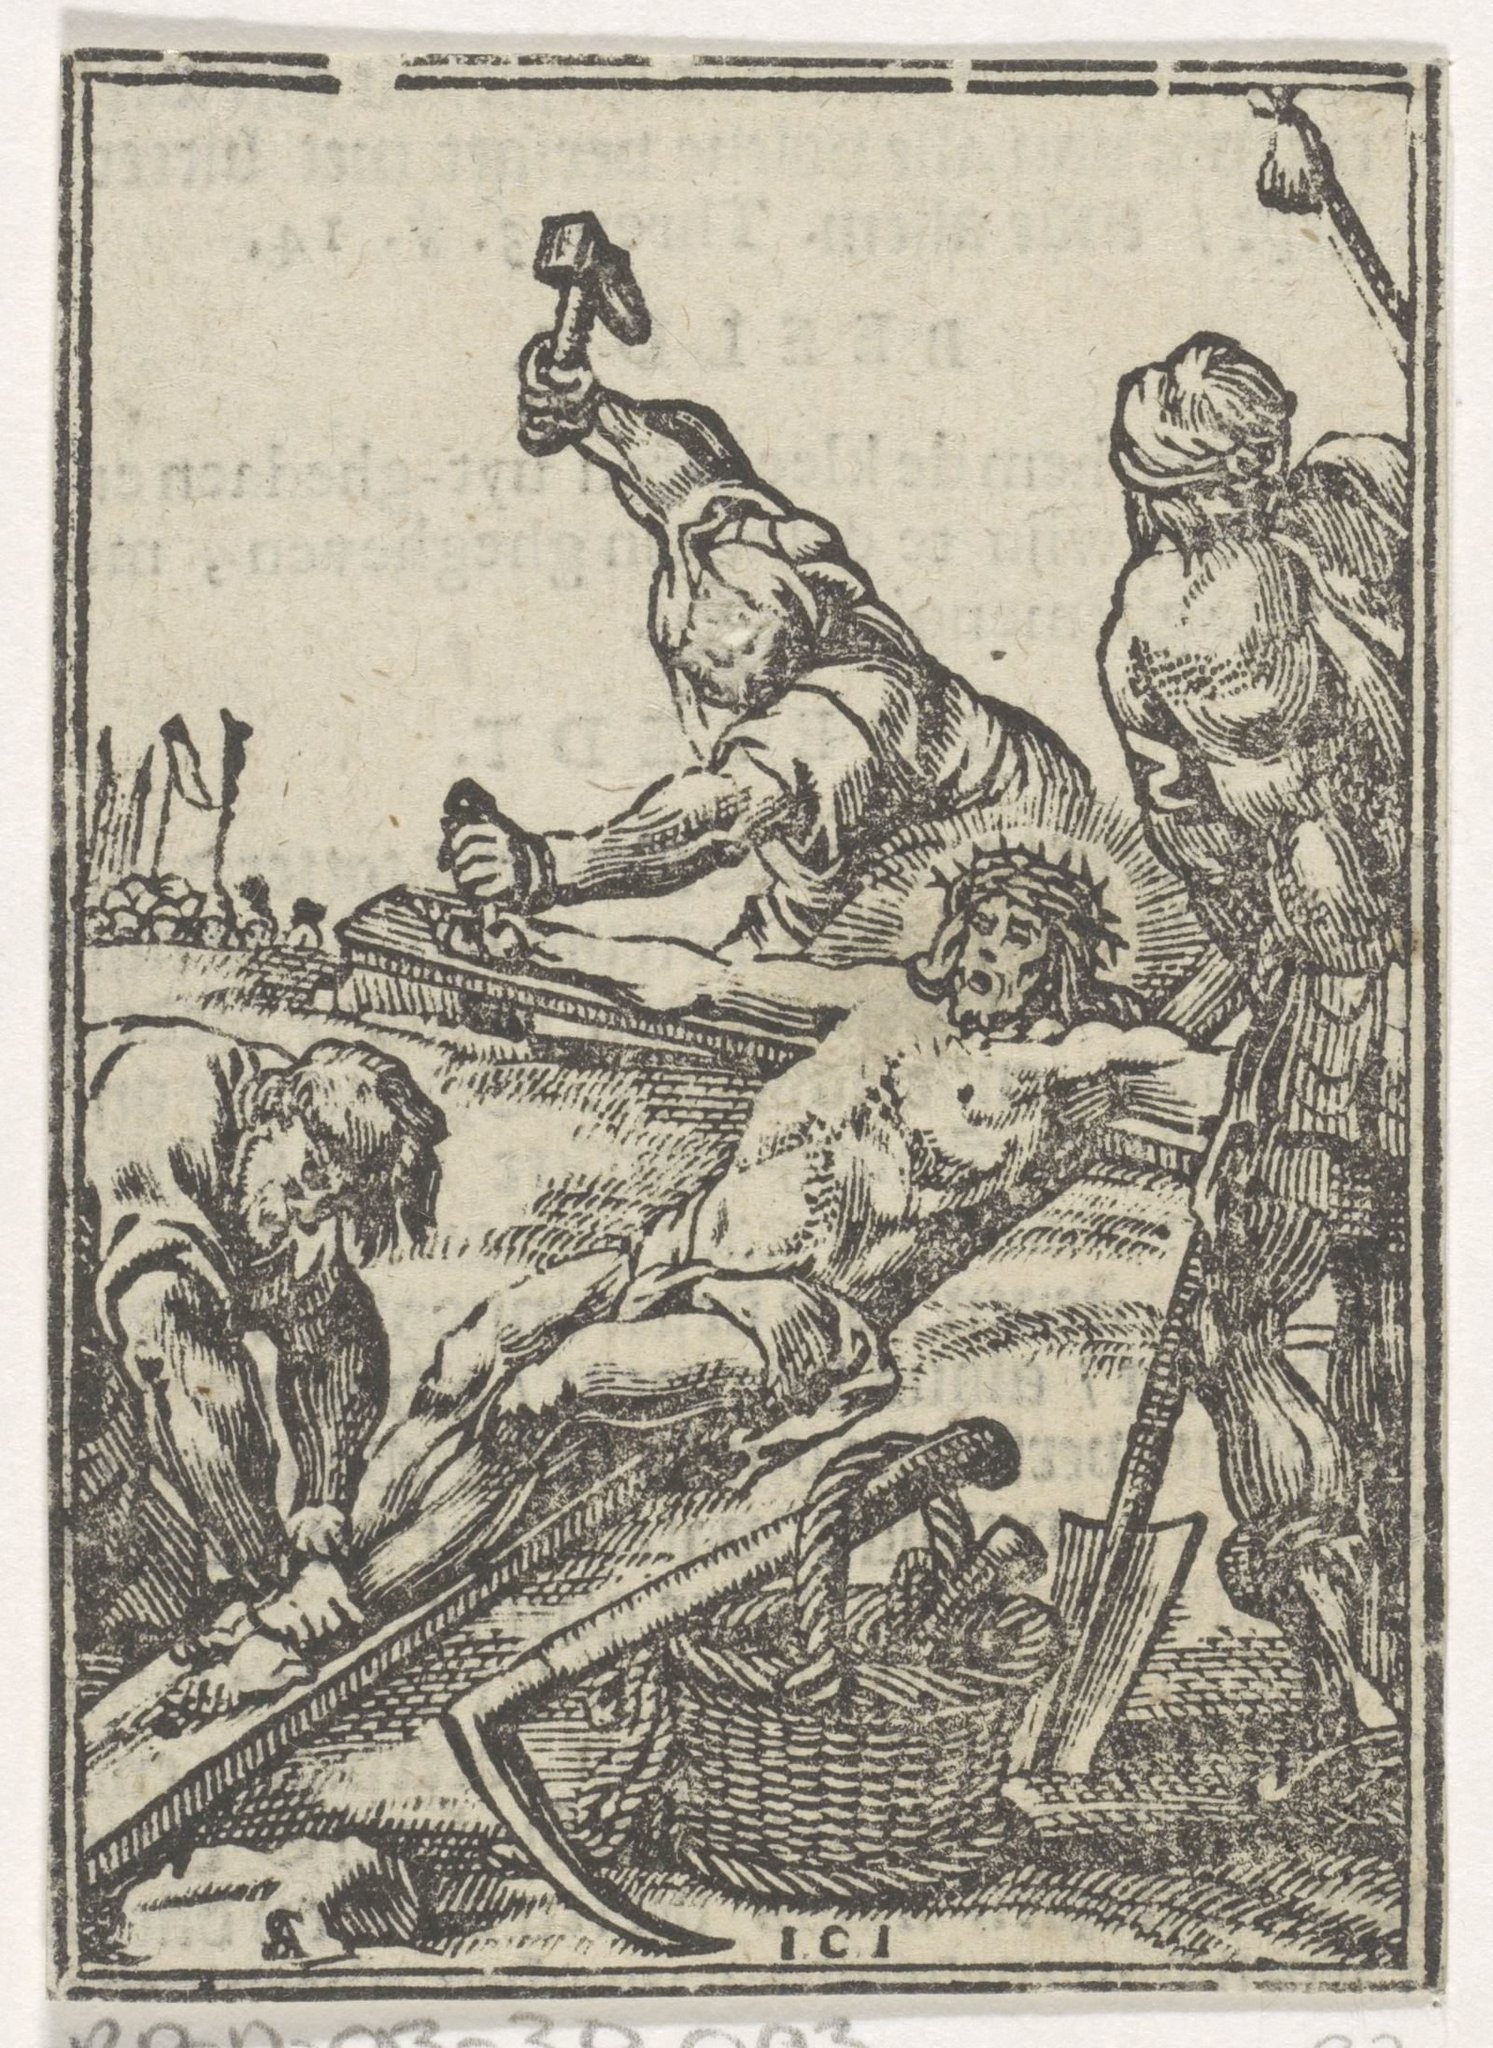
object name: print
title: Kruisiging van Christus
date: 1649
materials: paper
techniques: letterpress printing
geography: antwerp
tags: the erection of the cross: christ is nailed to the cross which lies on the ground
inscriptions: collector's mark: Lugt 240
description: Prent uit: Andries, Judocus. Perpetua crux sive passio Jesu Christi. Antwerpen: Cornelis Woons, 1649.